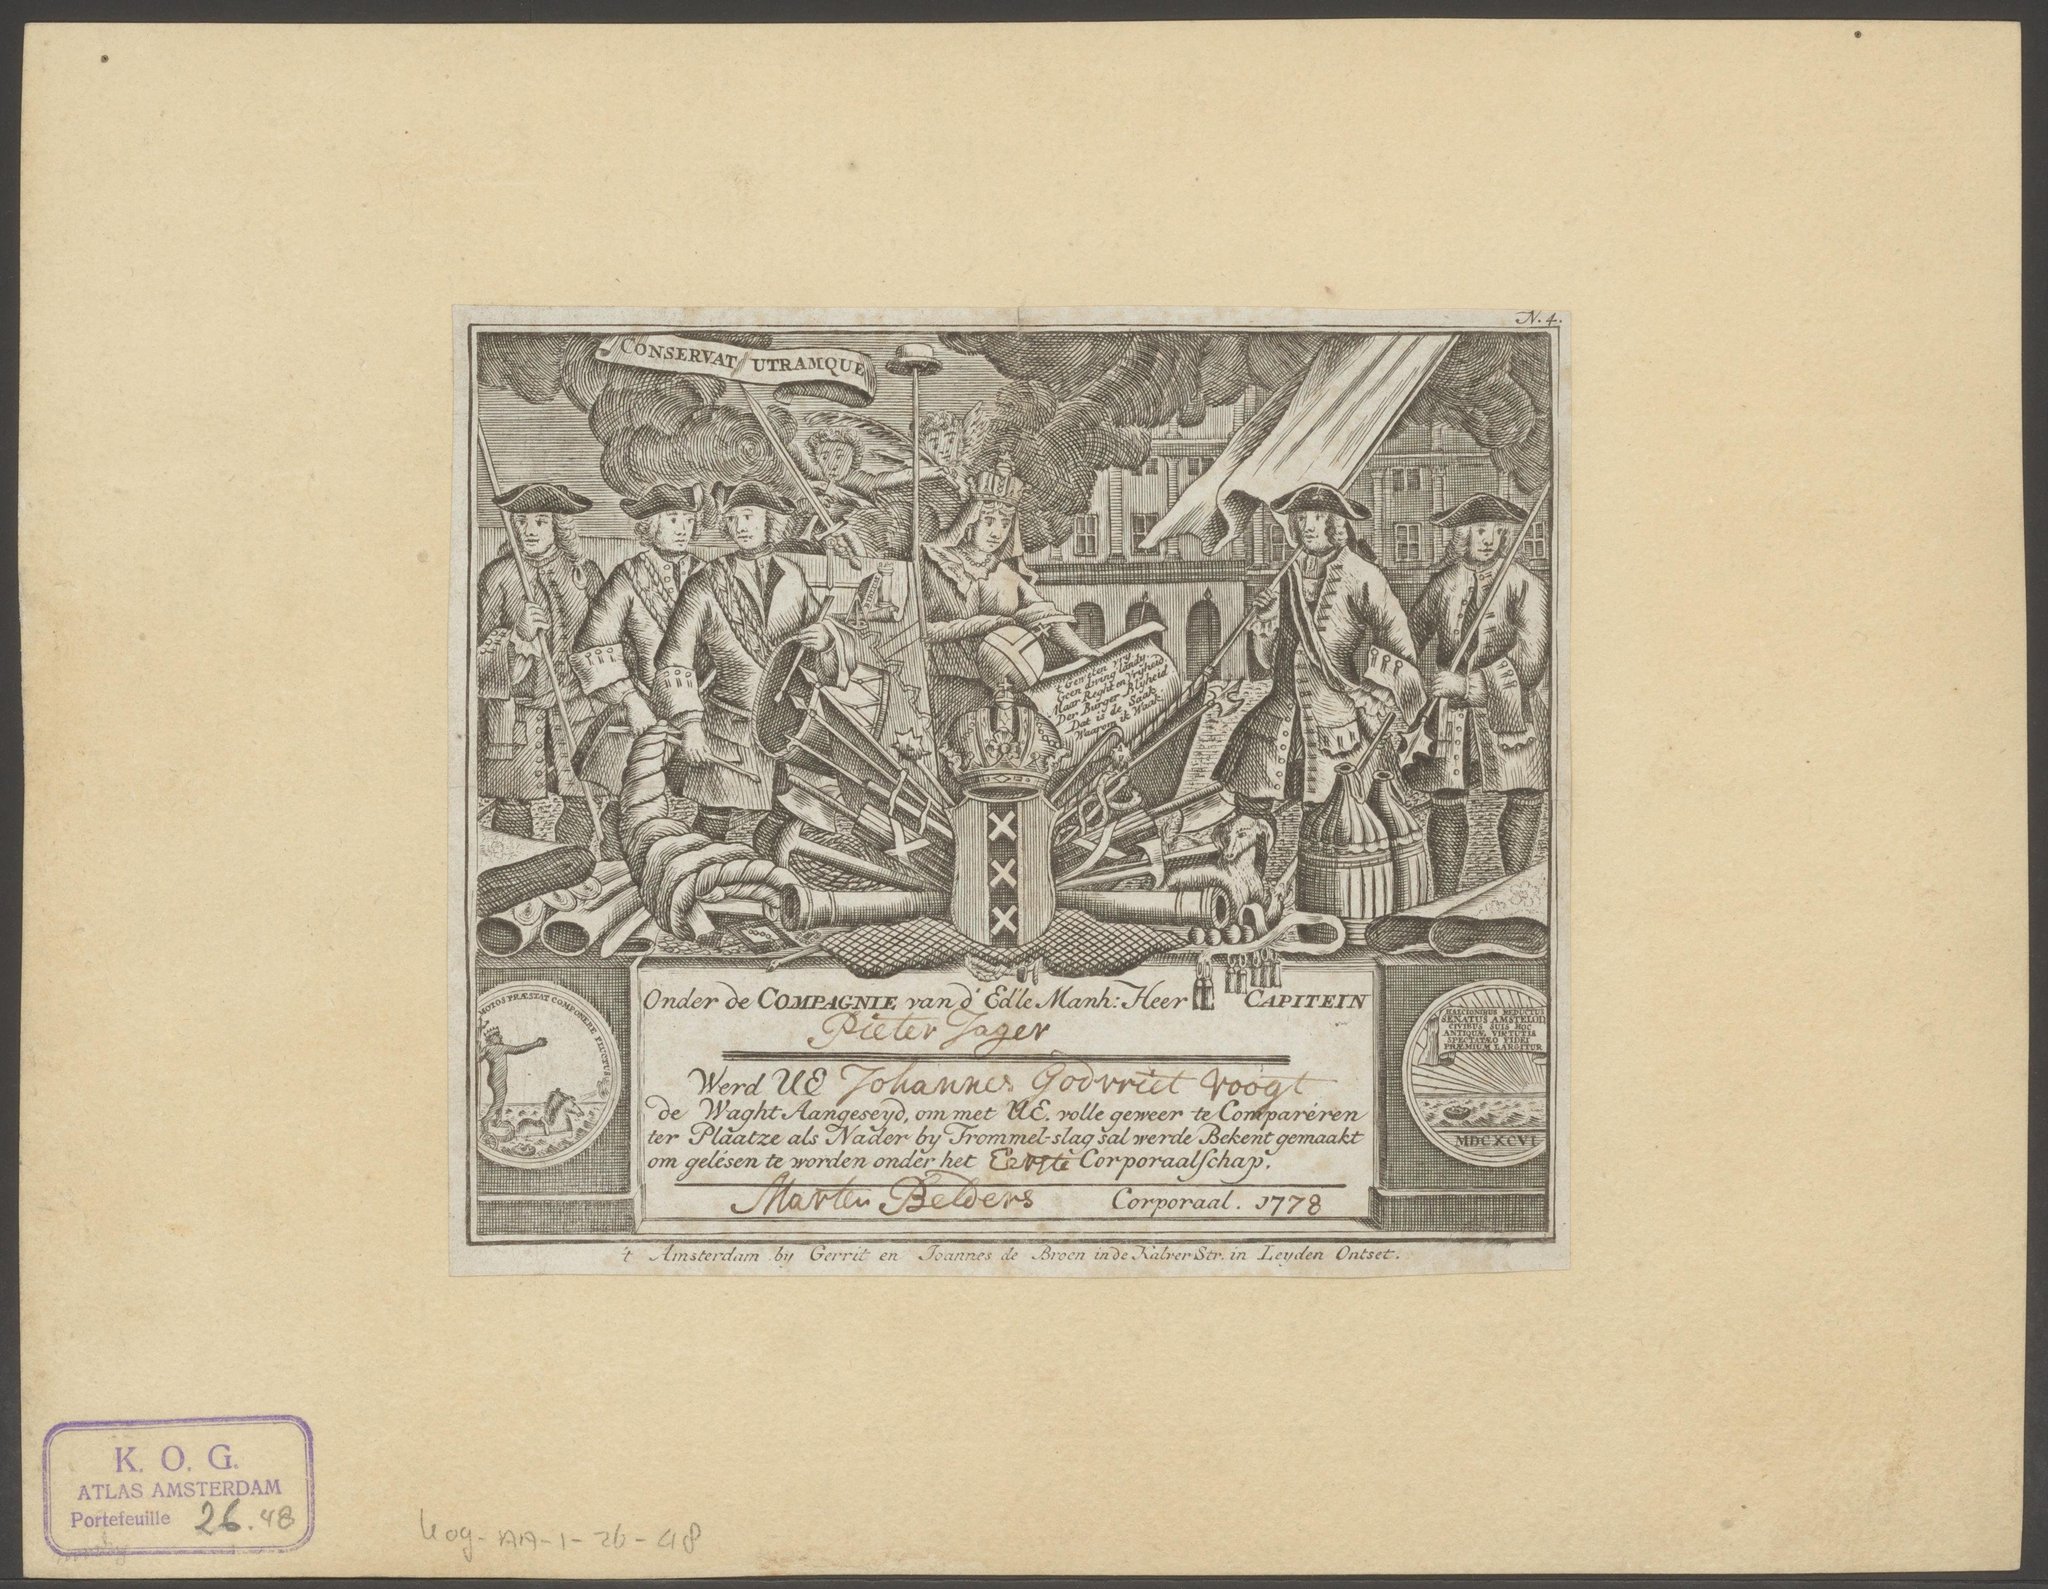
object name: schuttersbiljet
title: Schuttersbrief van kapitein Pieter Jager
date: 1778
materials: paper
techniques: engraving, etching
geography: amsterdam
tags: coat of arms (as symbol of the state, etc.) (+ city; municipal), personification of a city, town-patron(ess), military service (+ citizen soldiery, civil guard, citizen militia), amsterdam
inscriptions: collector's mark: Lugt 1641b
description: Schuttersbrief met oproep van kapitein Pieter Jager, gericht aan Johannes Godvriet Voogt, om zich bij het eerste korporaalschap van Marten Belders van de Amsterdamse schutterij te melden. Voorgedrukte brief met open delen die met pen zijn ingevuld. Rechtsboven genummerd: N. 4. Onderwerpsrubriek binnen de Atlas Amsterdam: Schutters-oproepingsbriefjes.